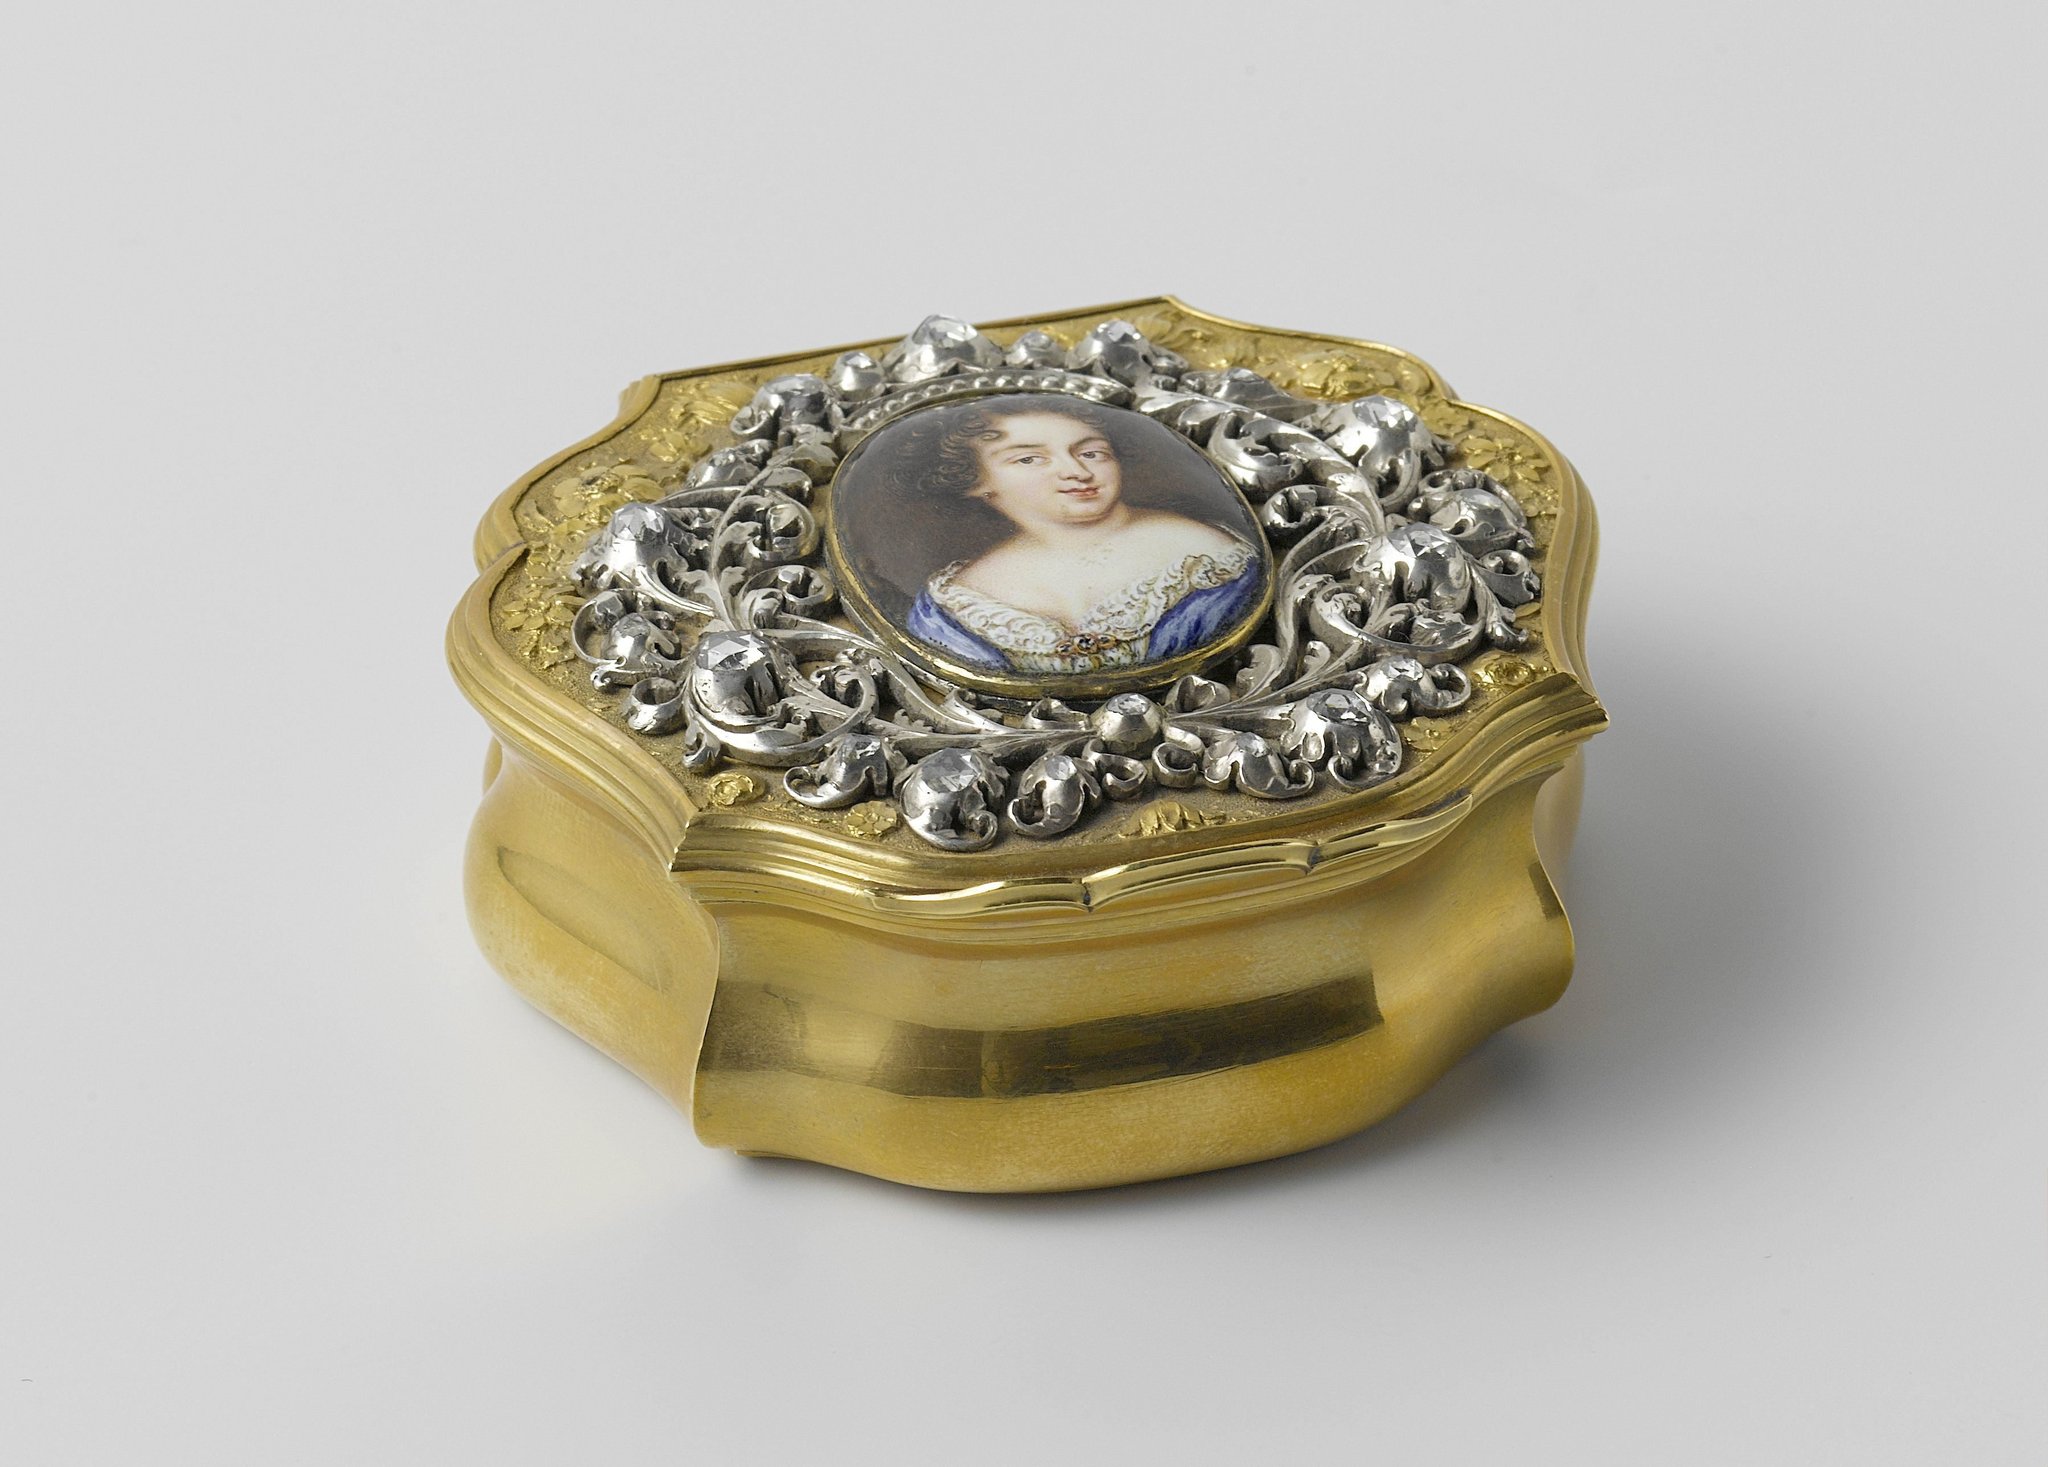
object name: snuffbox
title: Snuffbox with a breast ornament with a portrait of Queen Mary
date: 1752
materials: diamond, gold, silver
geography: amsterdam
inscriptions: mark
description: Miniature portraits of rulers played an important role in 17th-century diplomacy. An unusual variant arose around 1670 in which the miniatures were set in diamonds. This breast ornament was a gift from Queen Mary, consort of King-Stadtholder William III, to a confidante. It was later mounted on the lid of a gold snuffbox.